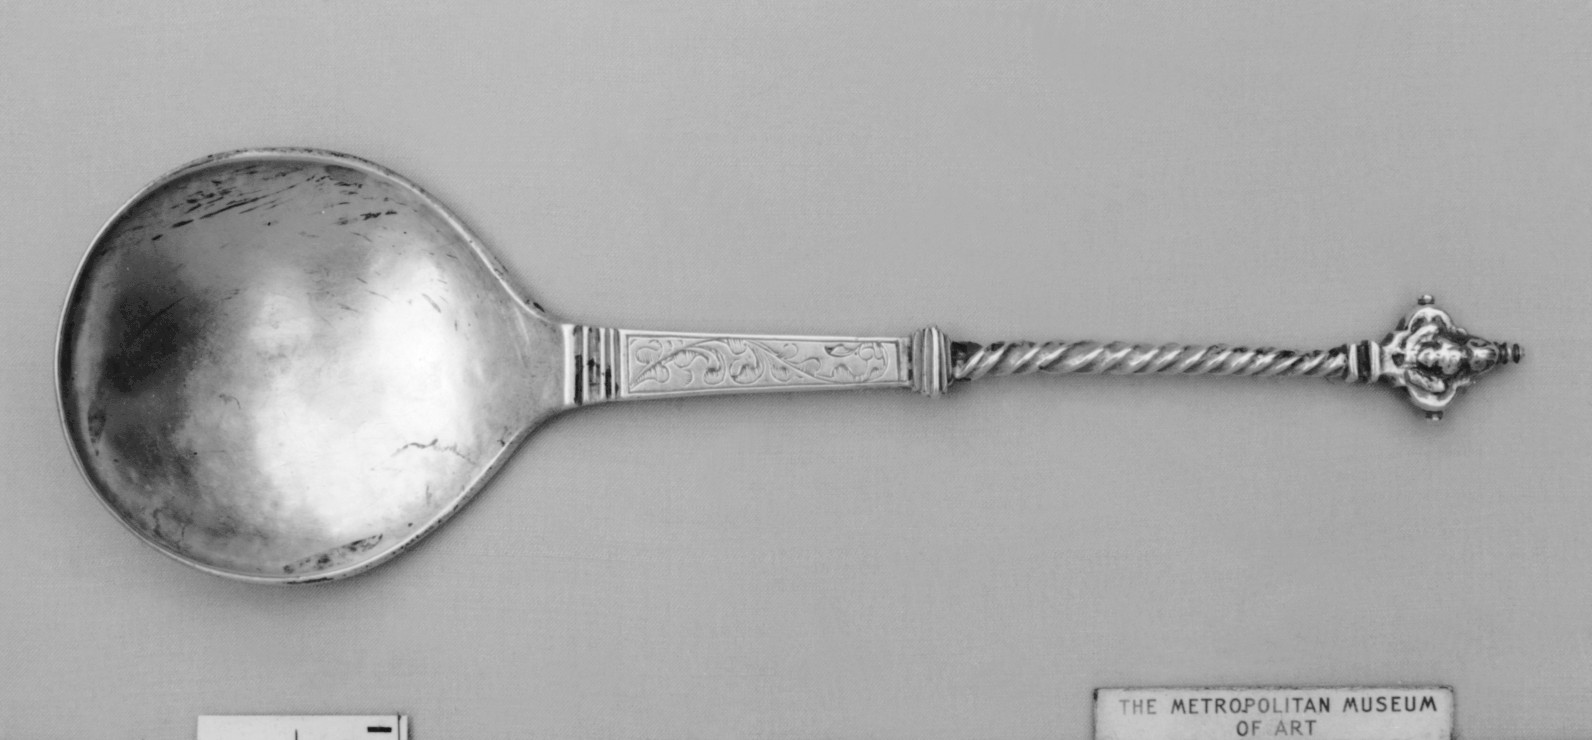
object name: spoon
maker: henrick van laer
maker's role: maker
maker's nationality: dutch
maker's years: 1615-1666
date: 1654-1655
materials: silver